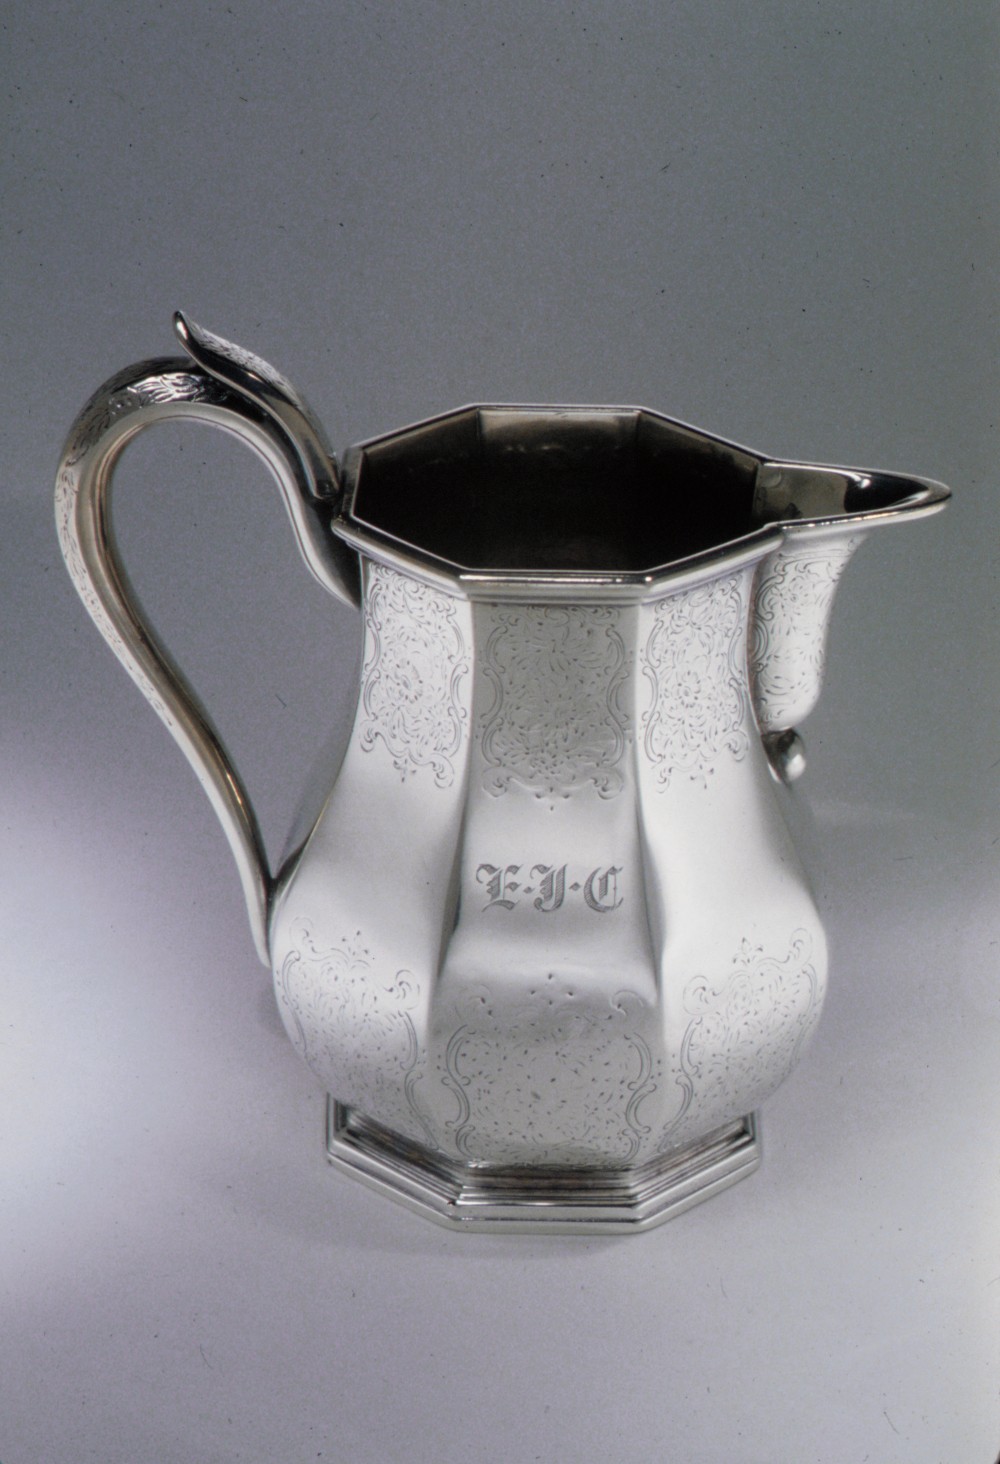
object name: cream pot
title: Creamer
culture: american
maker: william forbes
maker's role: maker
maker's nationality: american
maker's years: 1826-1863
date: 1840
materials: silver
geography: united states